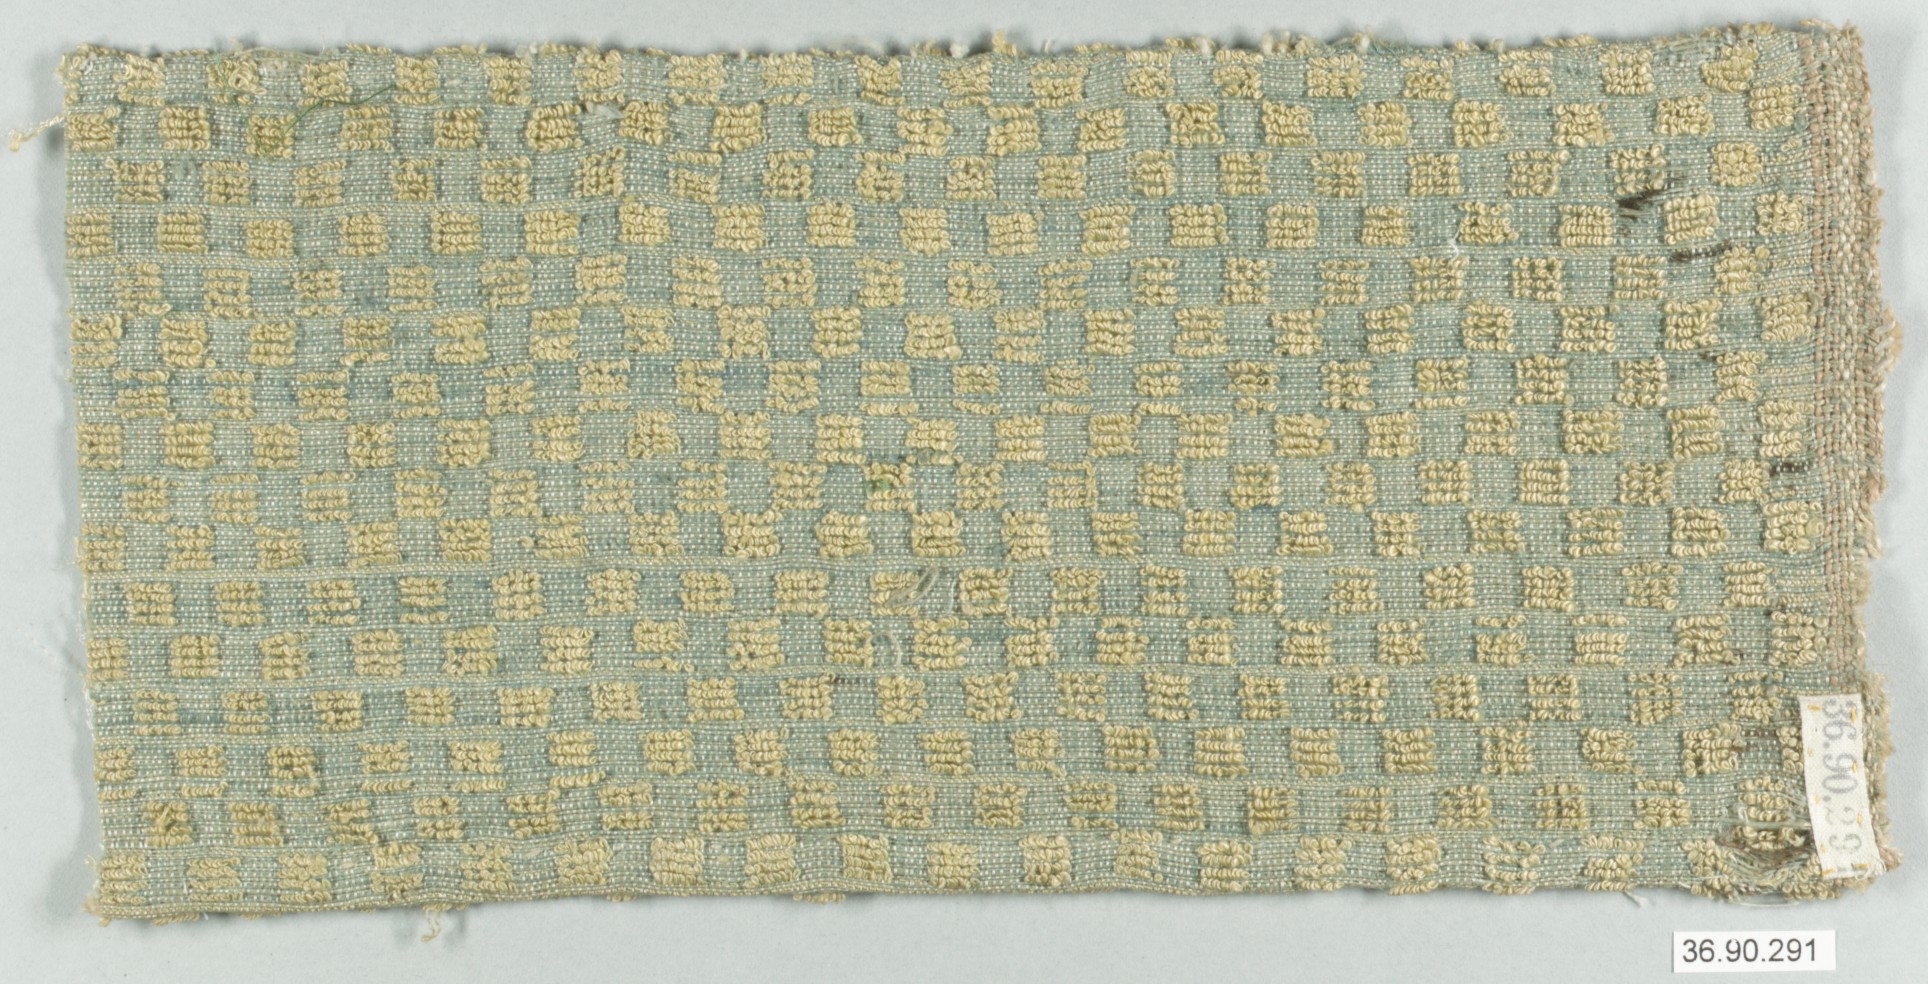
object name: piece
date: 1501-1700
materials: silk